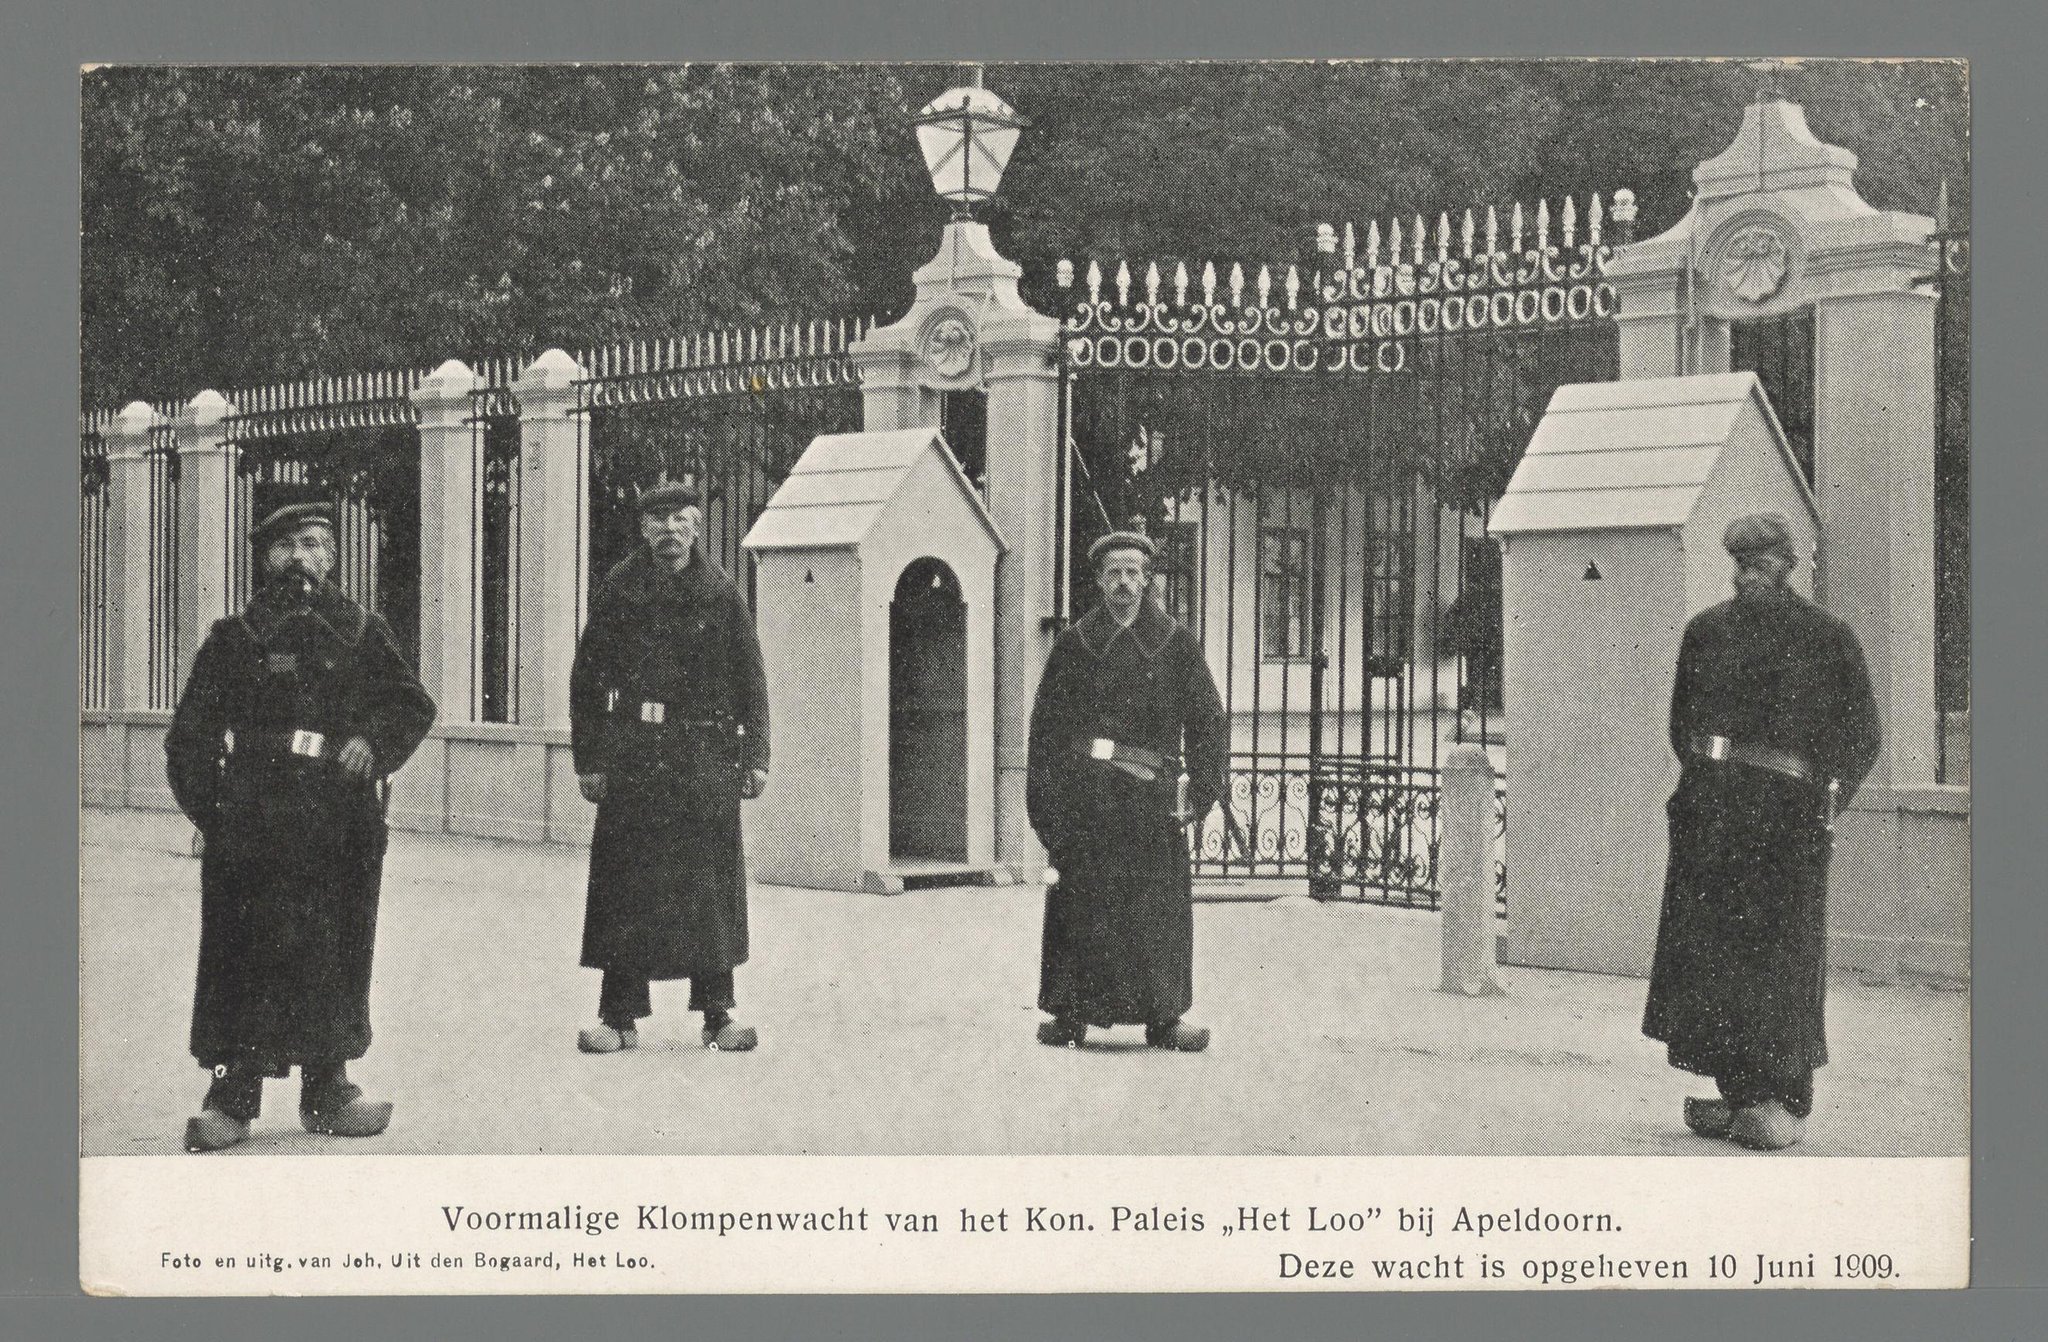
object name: photomechanical print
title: Voormalige klompenwacht van het Kon. Paleis "Het Loo" bij Apeldoorn. Deze wacht is opgeheven 10 juni 1909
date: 1909-1930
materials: cardboard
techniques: autotype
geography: apeldoorn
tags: wooden shoes, clogs, palace, gate, entrance